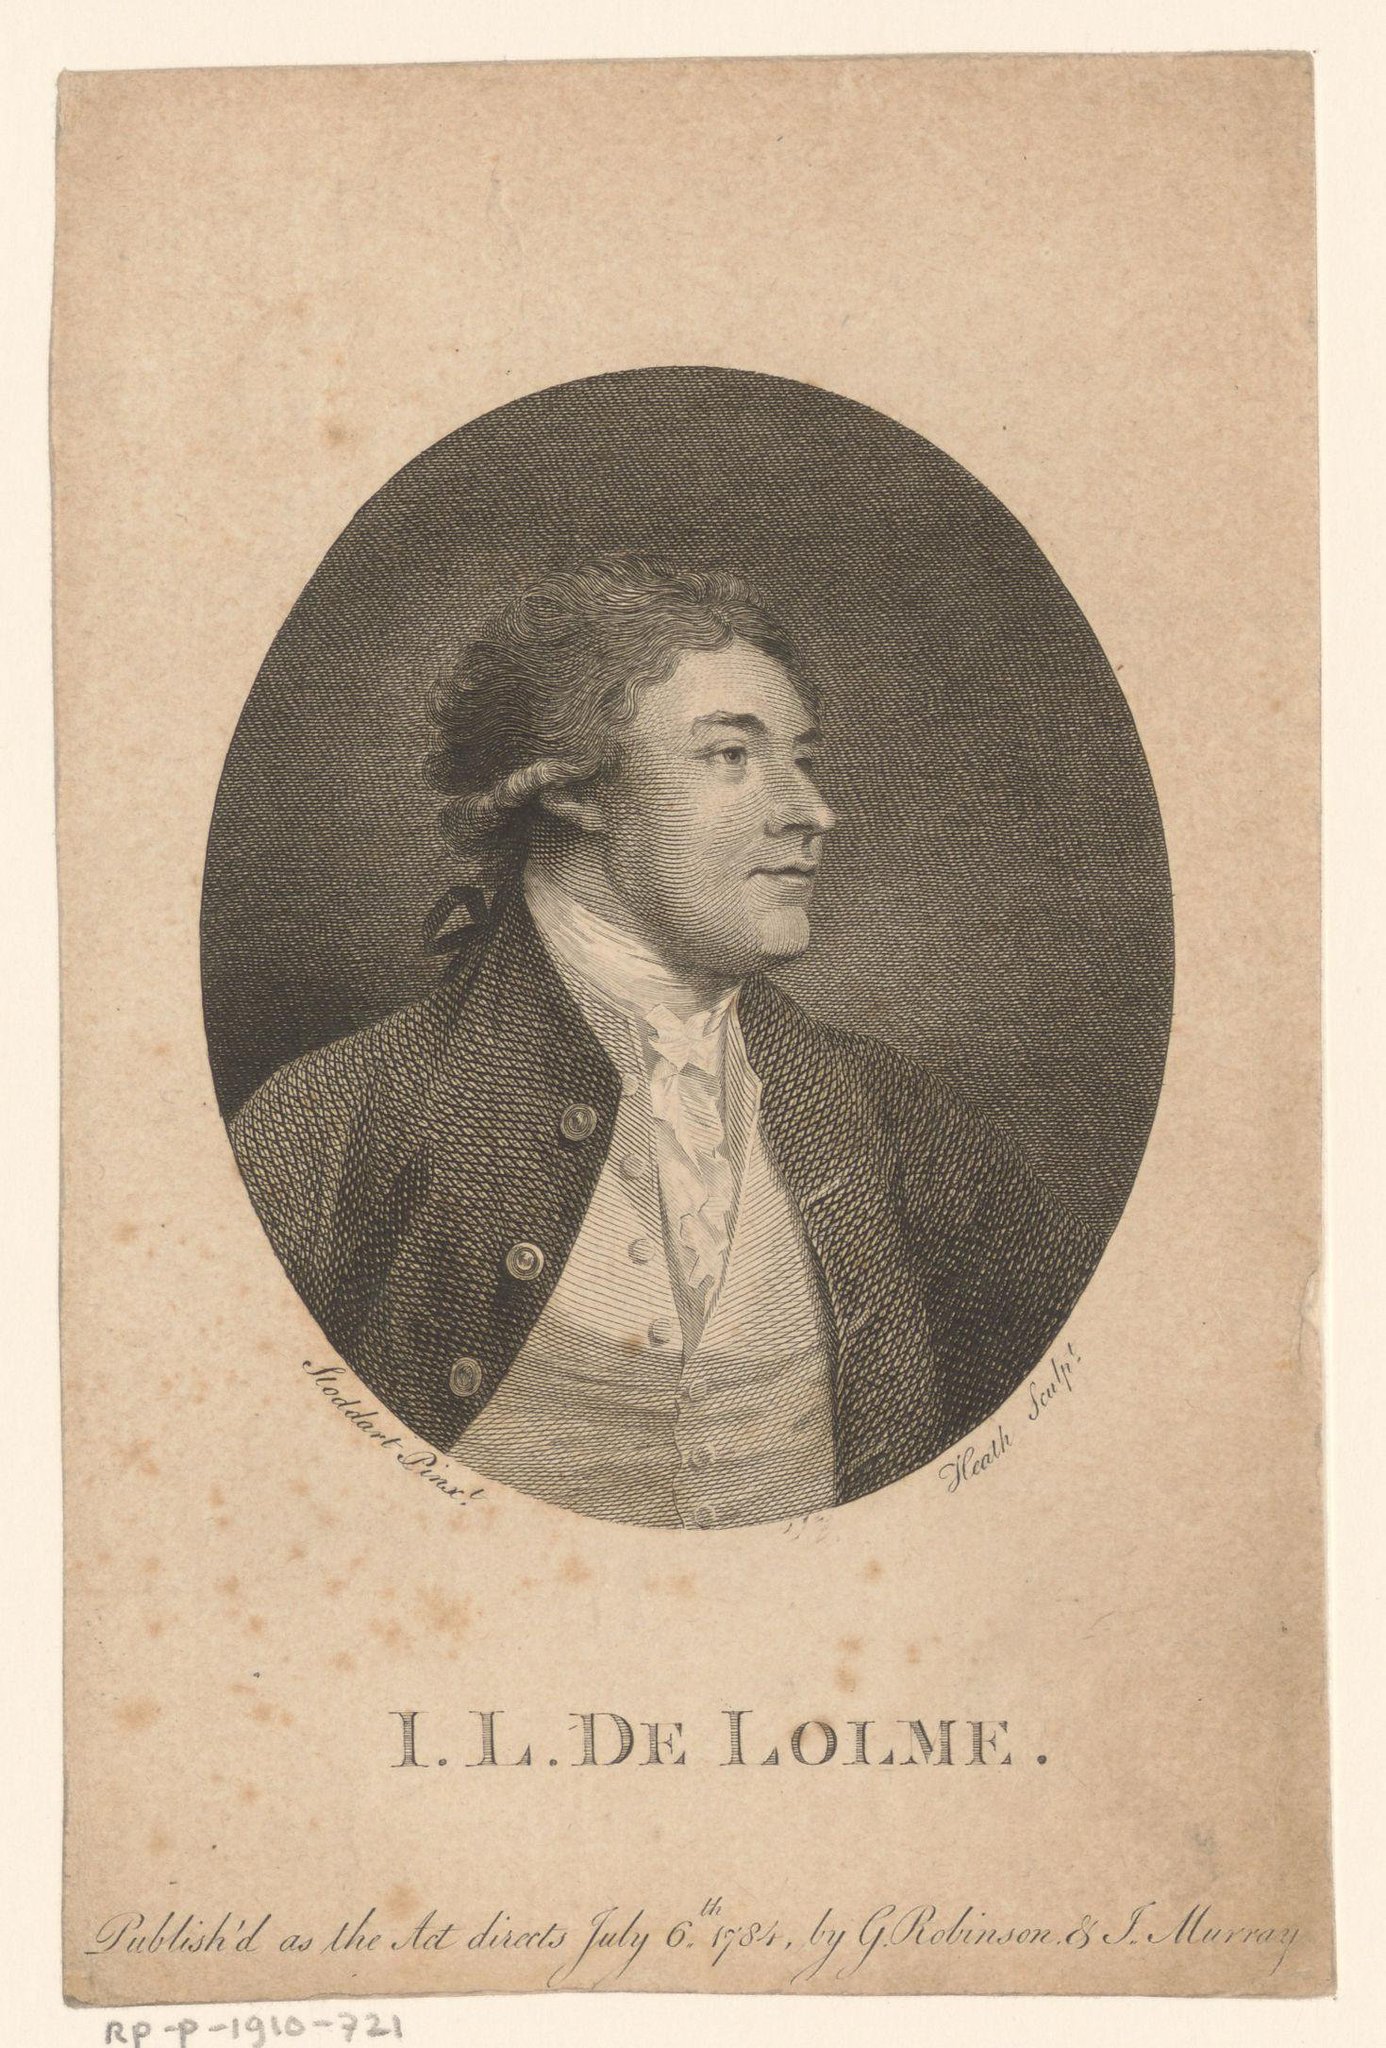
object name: print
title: Portret van Jean-Louis de Lolme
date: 1707-1784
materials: paper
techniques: engraving, etching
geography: london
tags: historical persons, portrait of a writer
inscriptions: collector's mark: Lugt 2228